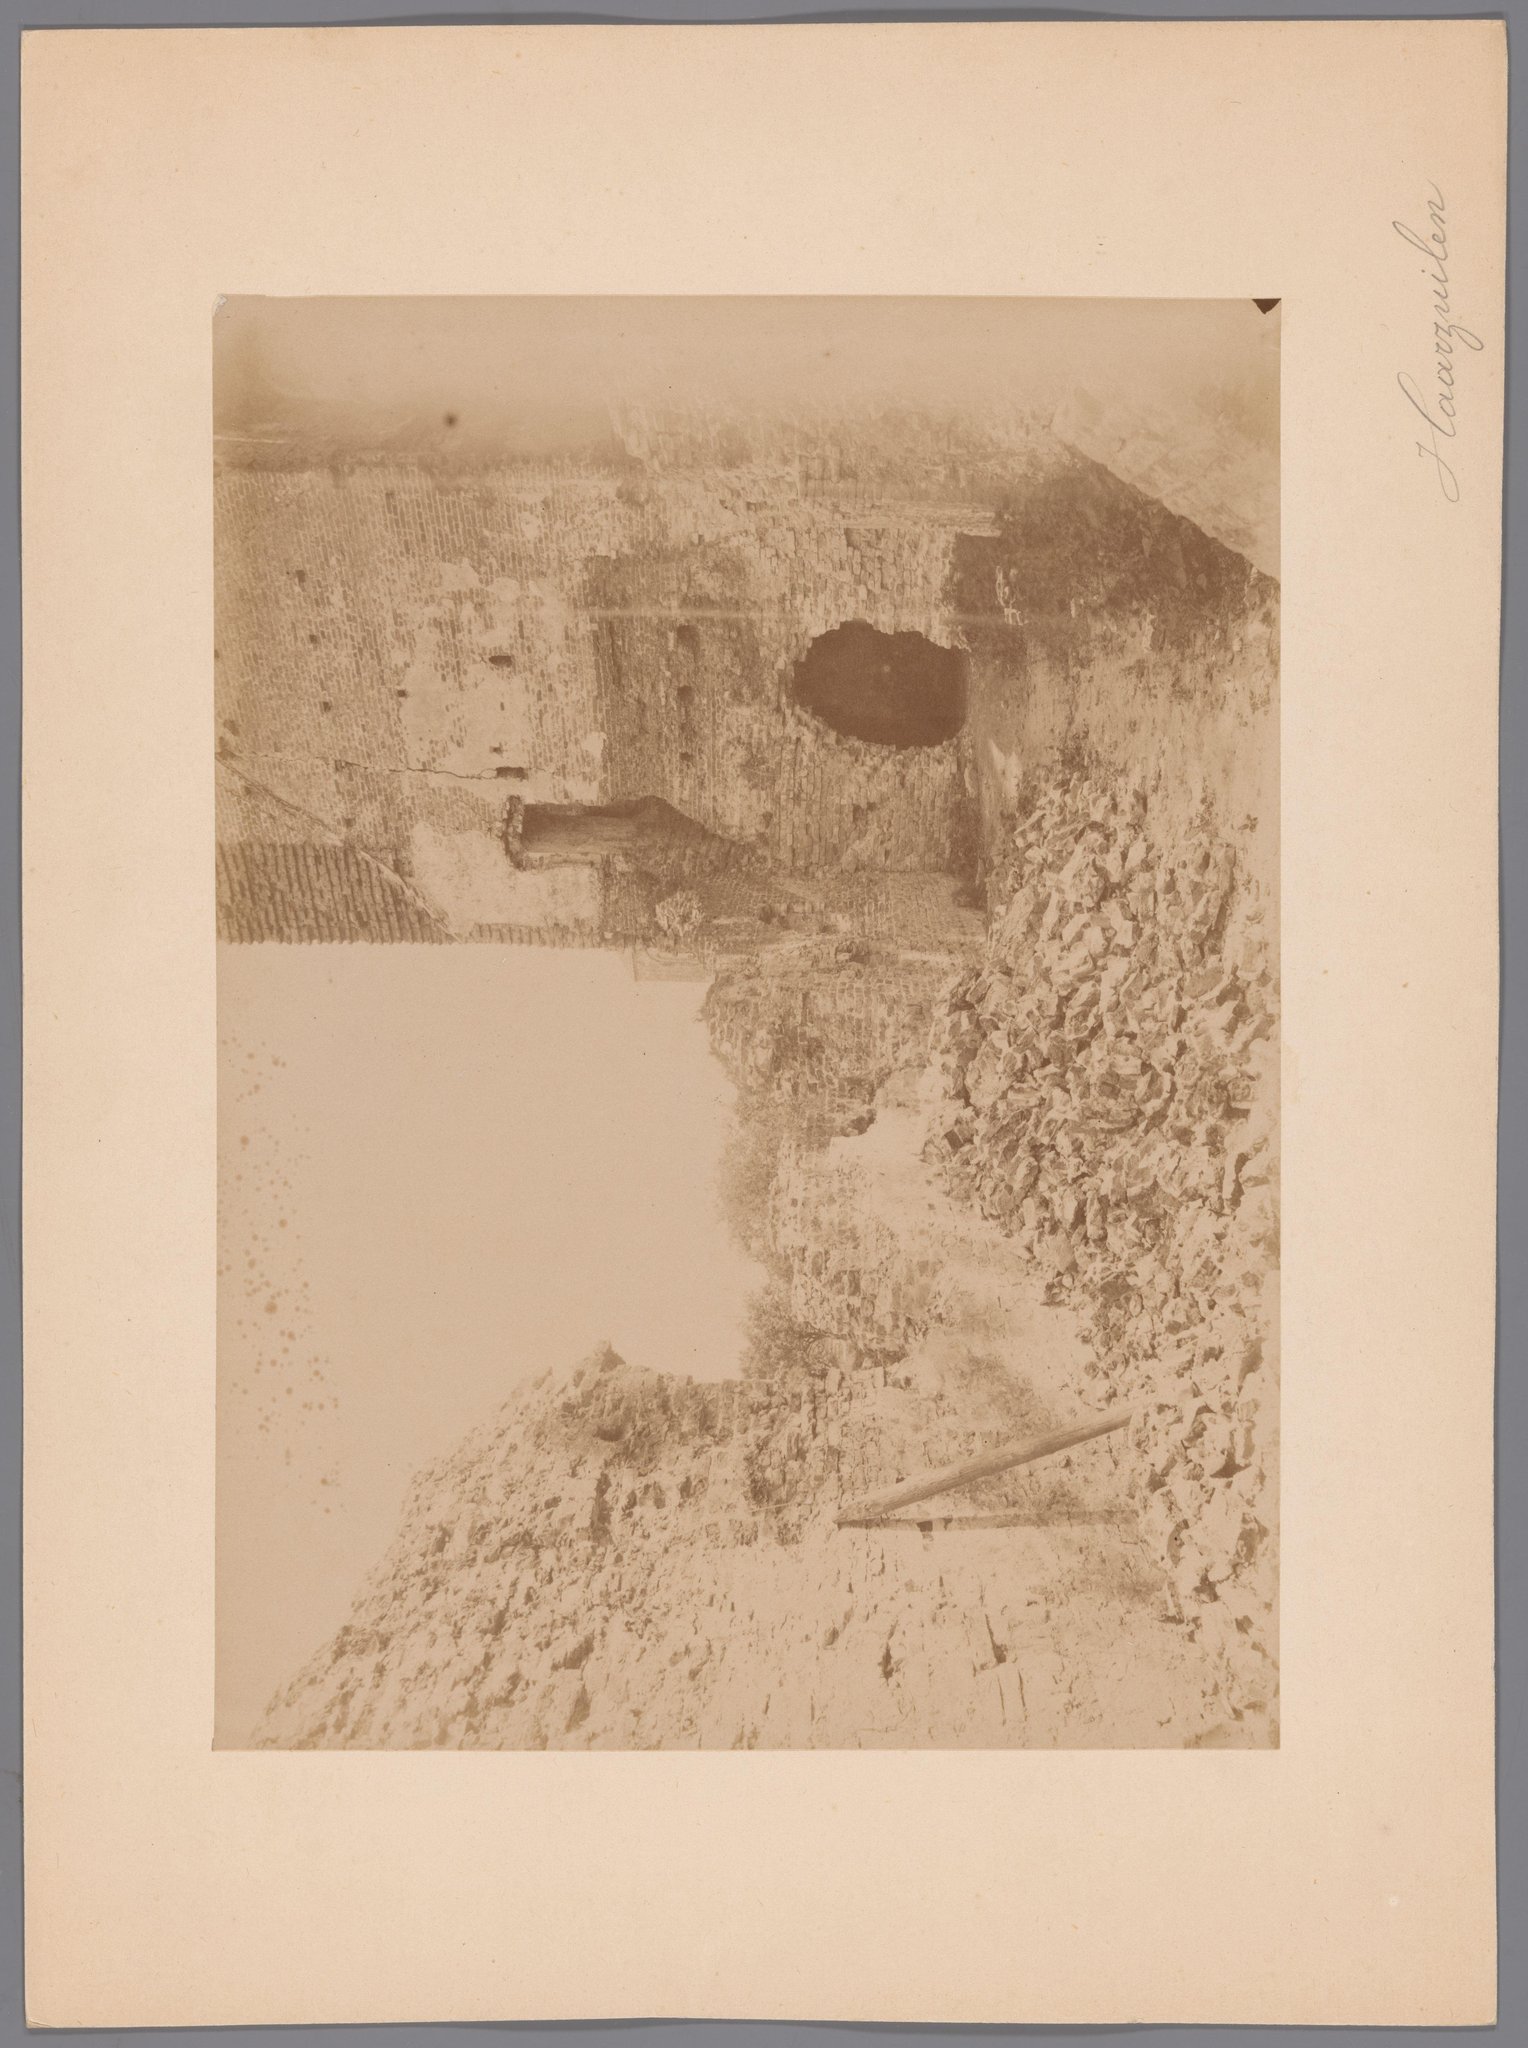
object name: photograph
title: Kelder in de ruïne van Kasteel de Haar te Haarzuilens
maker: anoniem (monumentenzorg)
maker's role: fotograaf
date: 1892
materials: cardboard, photographic support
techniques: albumen print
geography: haarzuilens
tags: basement, cellar, ruin of a dwelling, house, castle, etc.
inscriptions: annotation: ‘Ruïne van het huis de Haar te Haarzuilen/ Na de ontgraving july 1892/ kelder aan de oostzijde gezien van af het noorden’, annotation: ‘Haarzuilen’